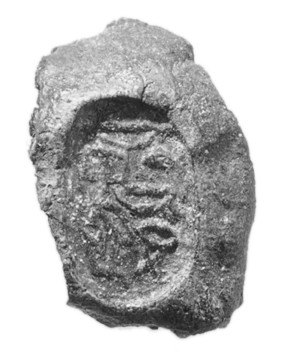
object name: sealing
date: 1981-1640 BCE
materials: mud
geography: egypt